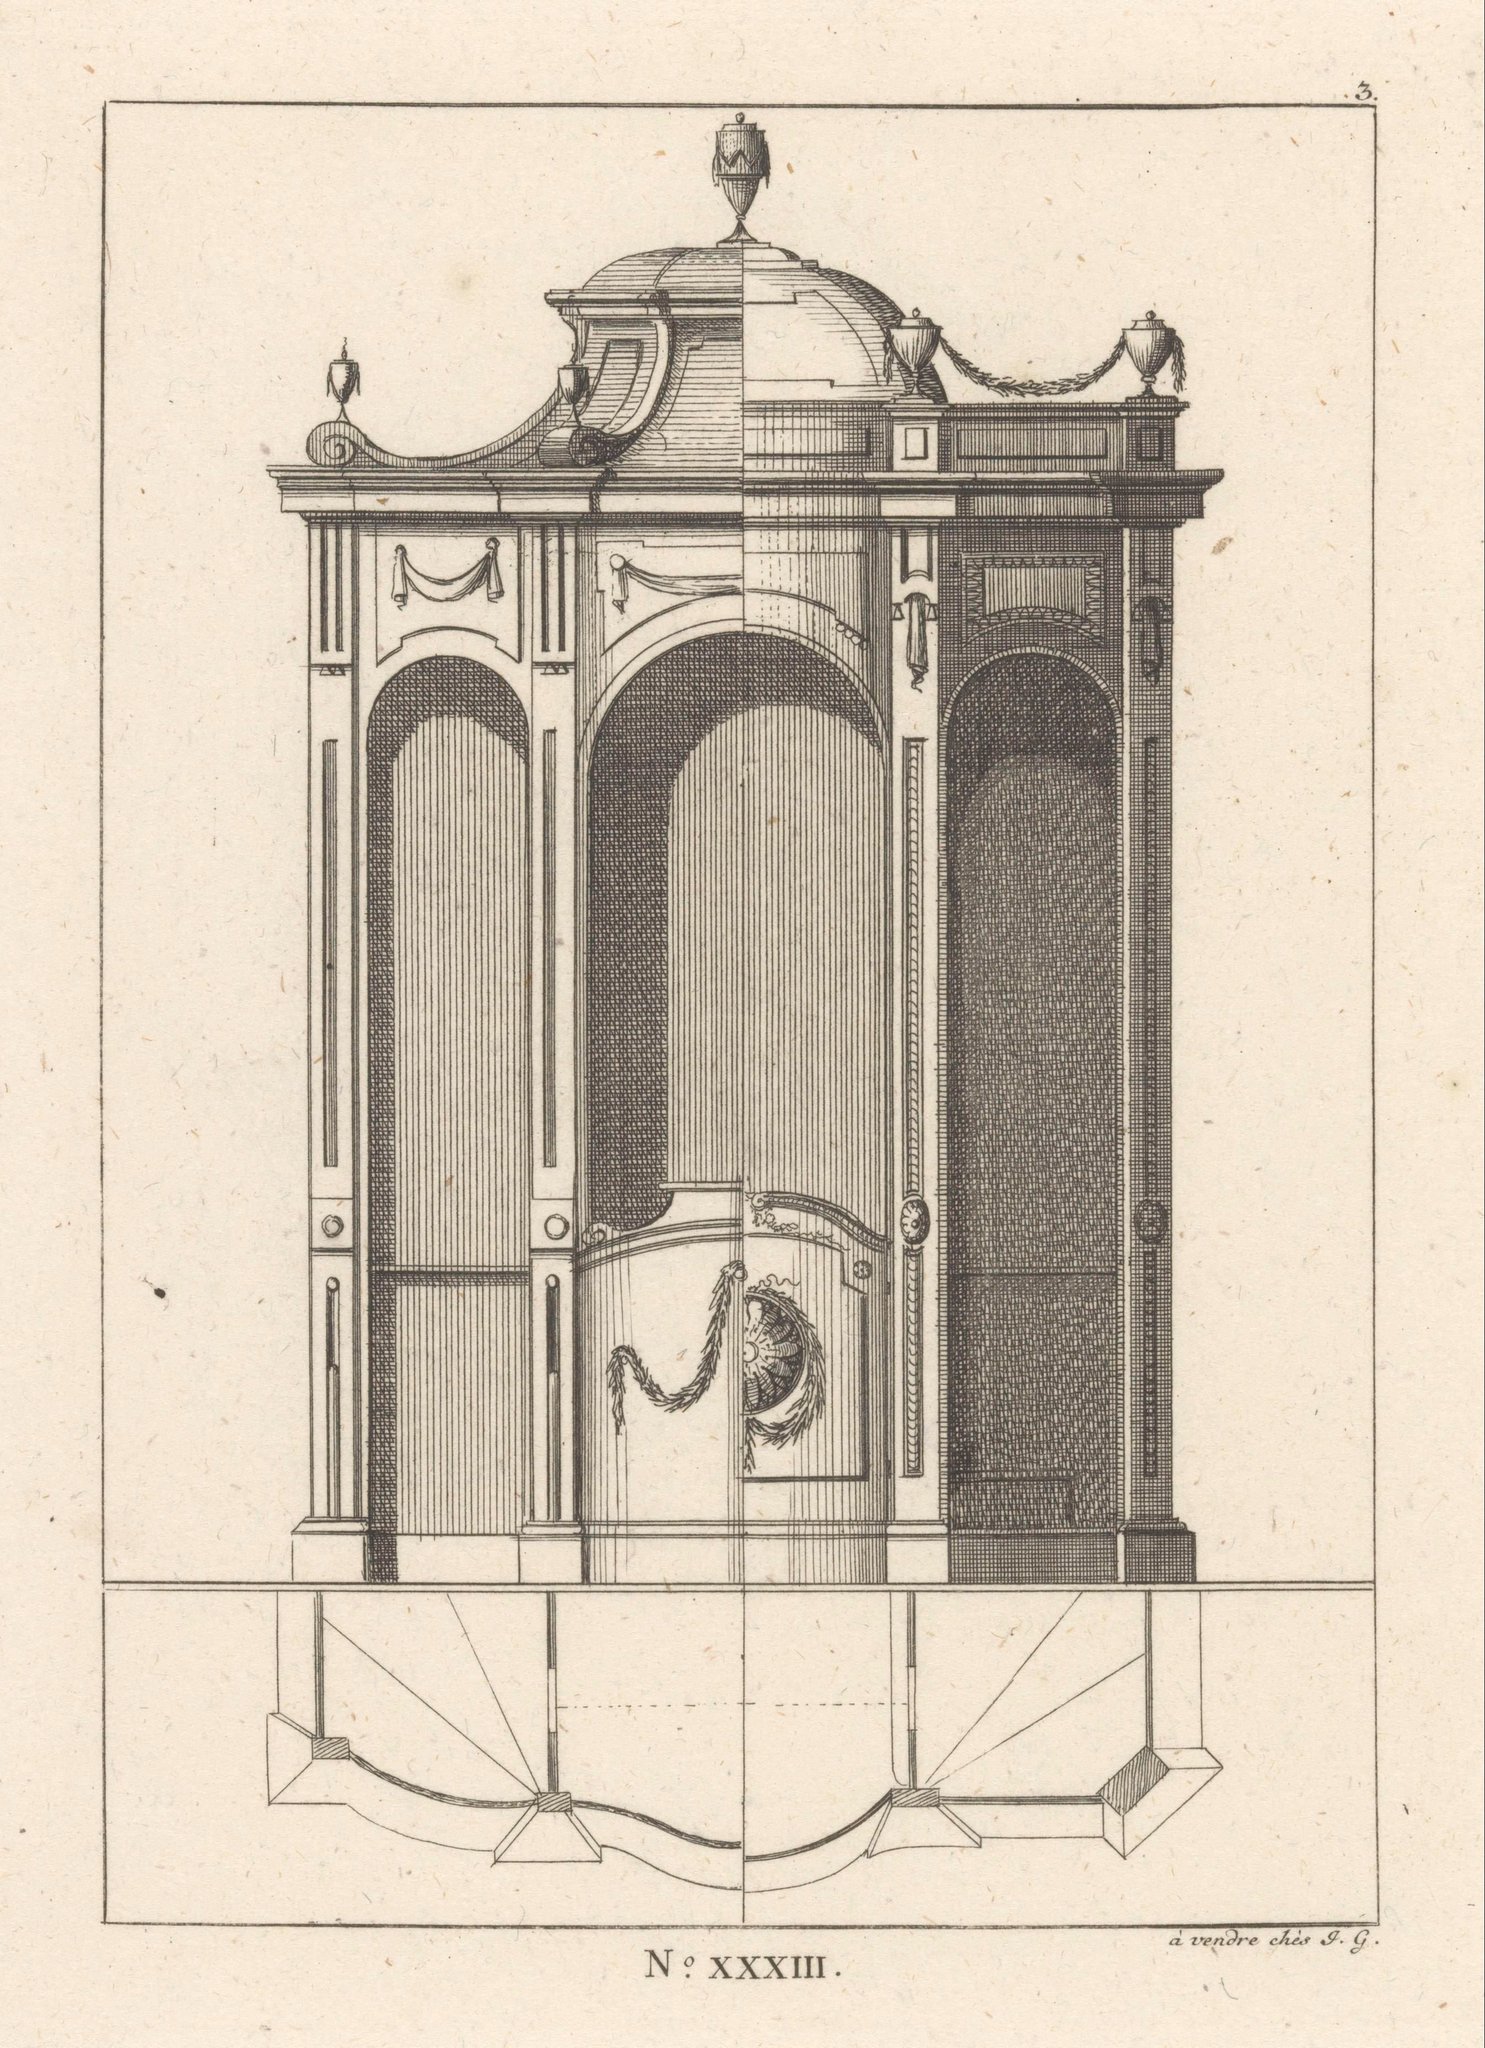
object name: print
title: Tabernakels en biechtstoelen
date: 1780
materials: paper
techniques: engraving, etching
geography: ravensburg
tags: confessional ~ part of the confession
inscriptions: collector's mark: Lugt 2760, collector's mark: Lugt 2228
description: Ontwerp en plattegrond van een biechtstoel met vazen en guirlandes. Uitgeversnummer XXXIII.